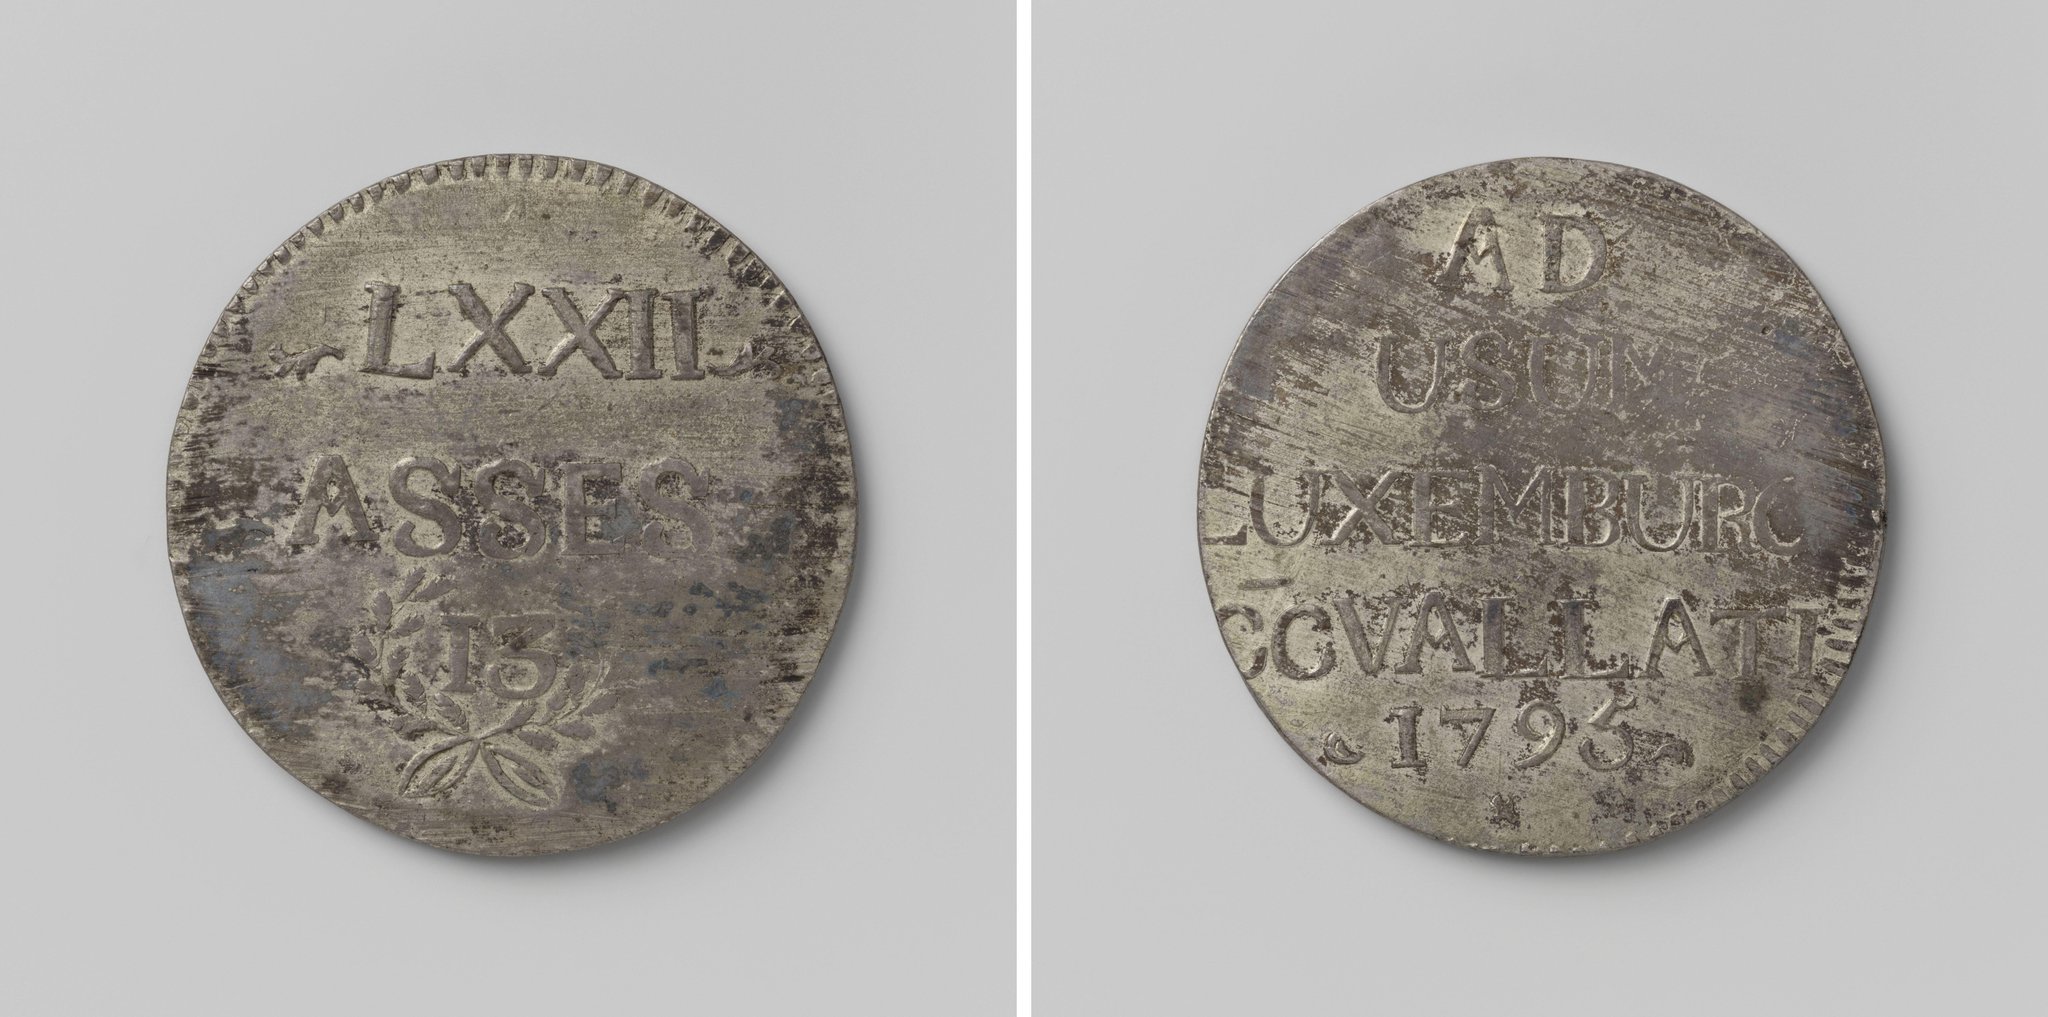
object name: siege coin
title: Beleg van Luxemburg door de Fransen, noodmunt van tweeenzeventig asses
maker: Anonymous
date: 1795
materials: silver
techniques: striking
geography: luxembourg city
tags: luxemburg (stad), franse revolutie, eerste coalitie-oorlog, beleg van luxemburg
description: Voorzijde: waardeaanduiding boven cijfer 13 in eikekrans. Keerzijde: opschrift